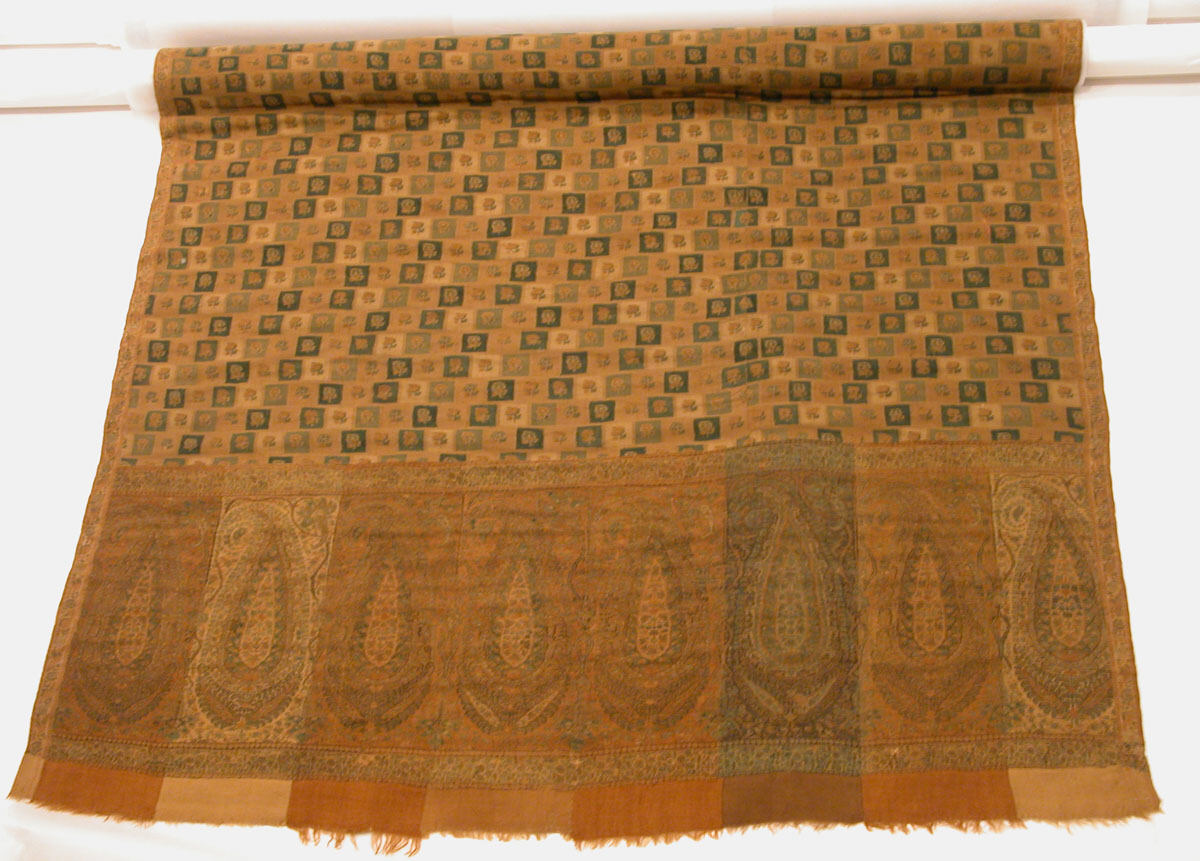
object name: shawl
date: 1810-1820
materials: wool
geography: india